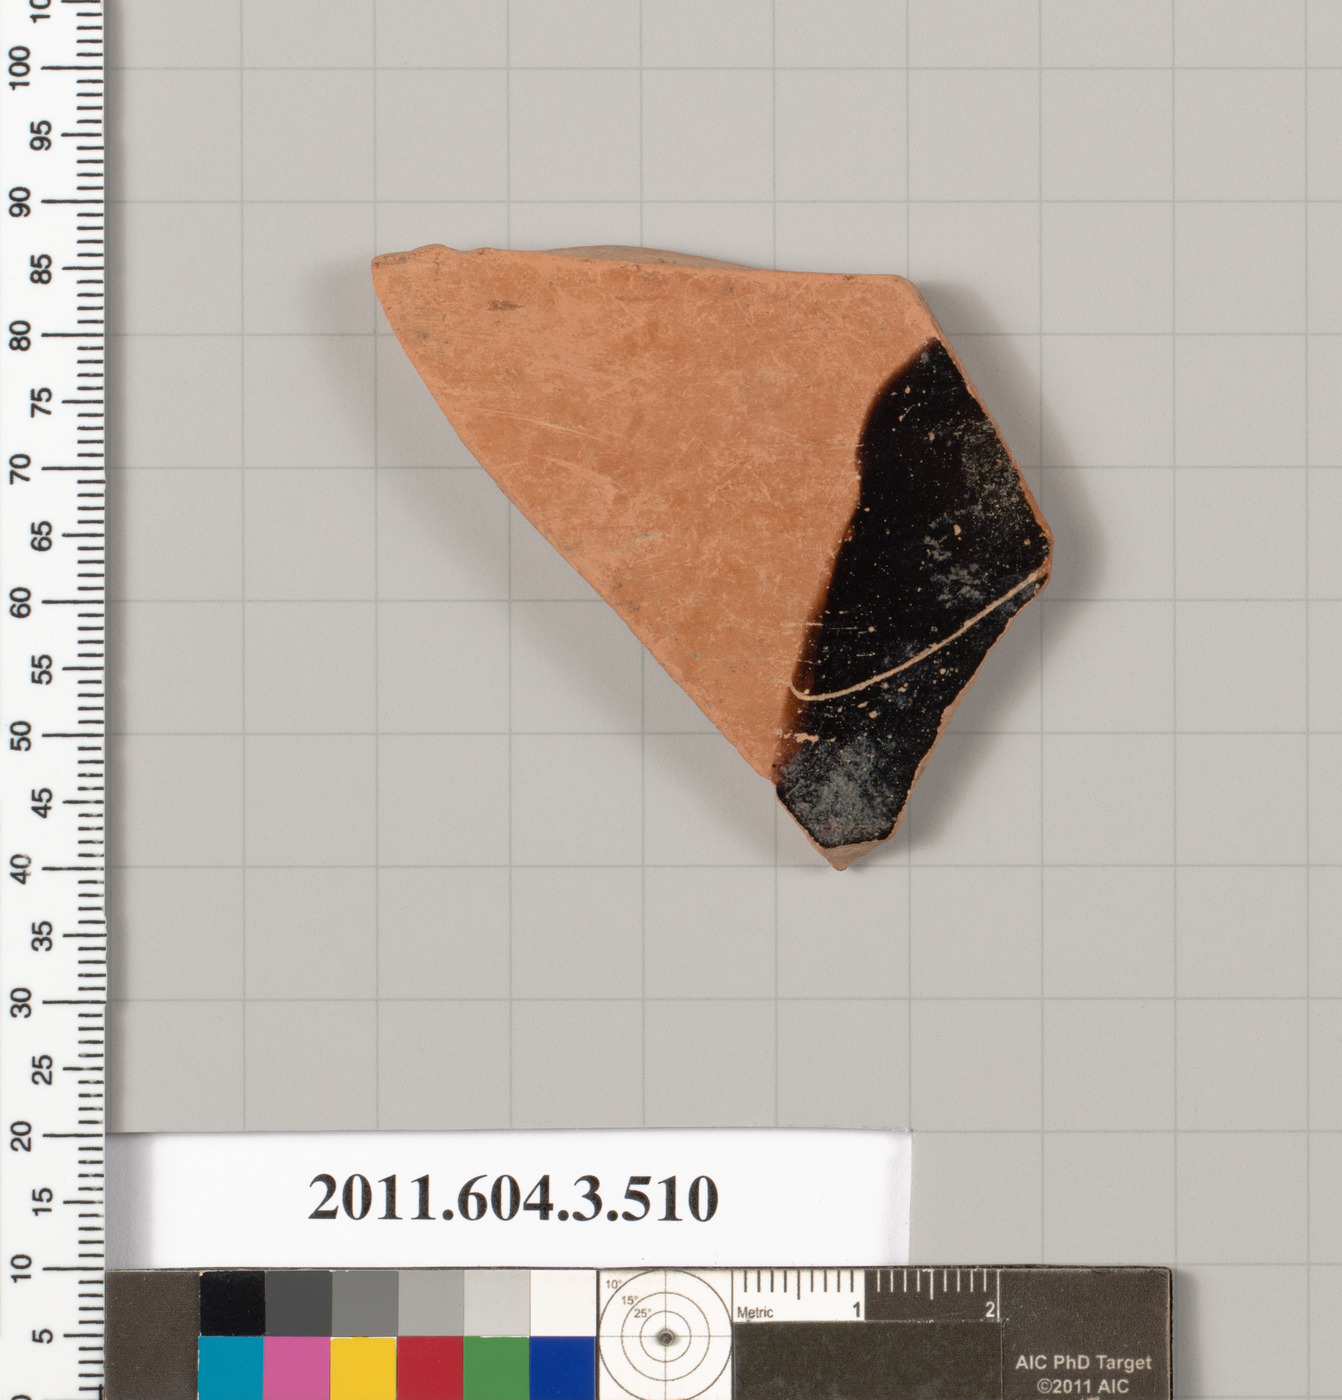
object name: column krater fragment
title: Terracotta fragment of a column-krater (bowl for mixing wine and water)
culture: greek, attic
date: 525-501 BCE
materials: terracotta